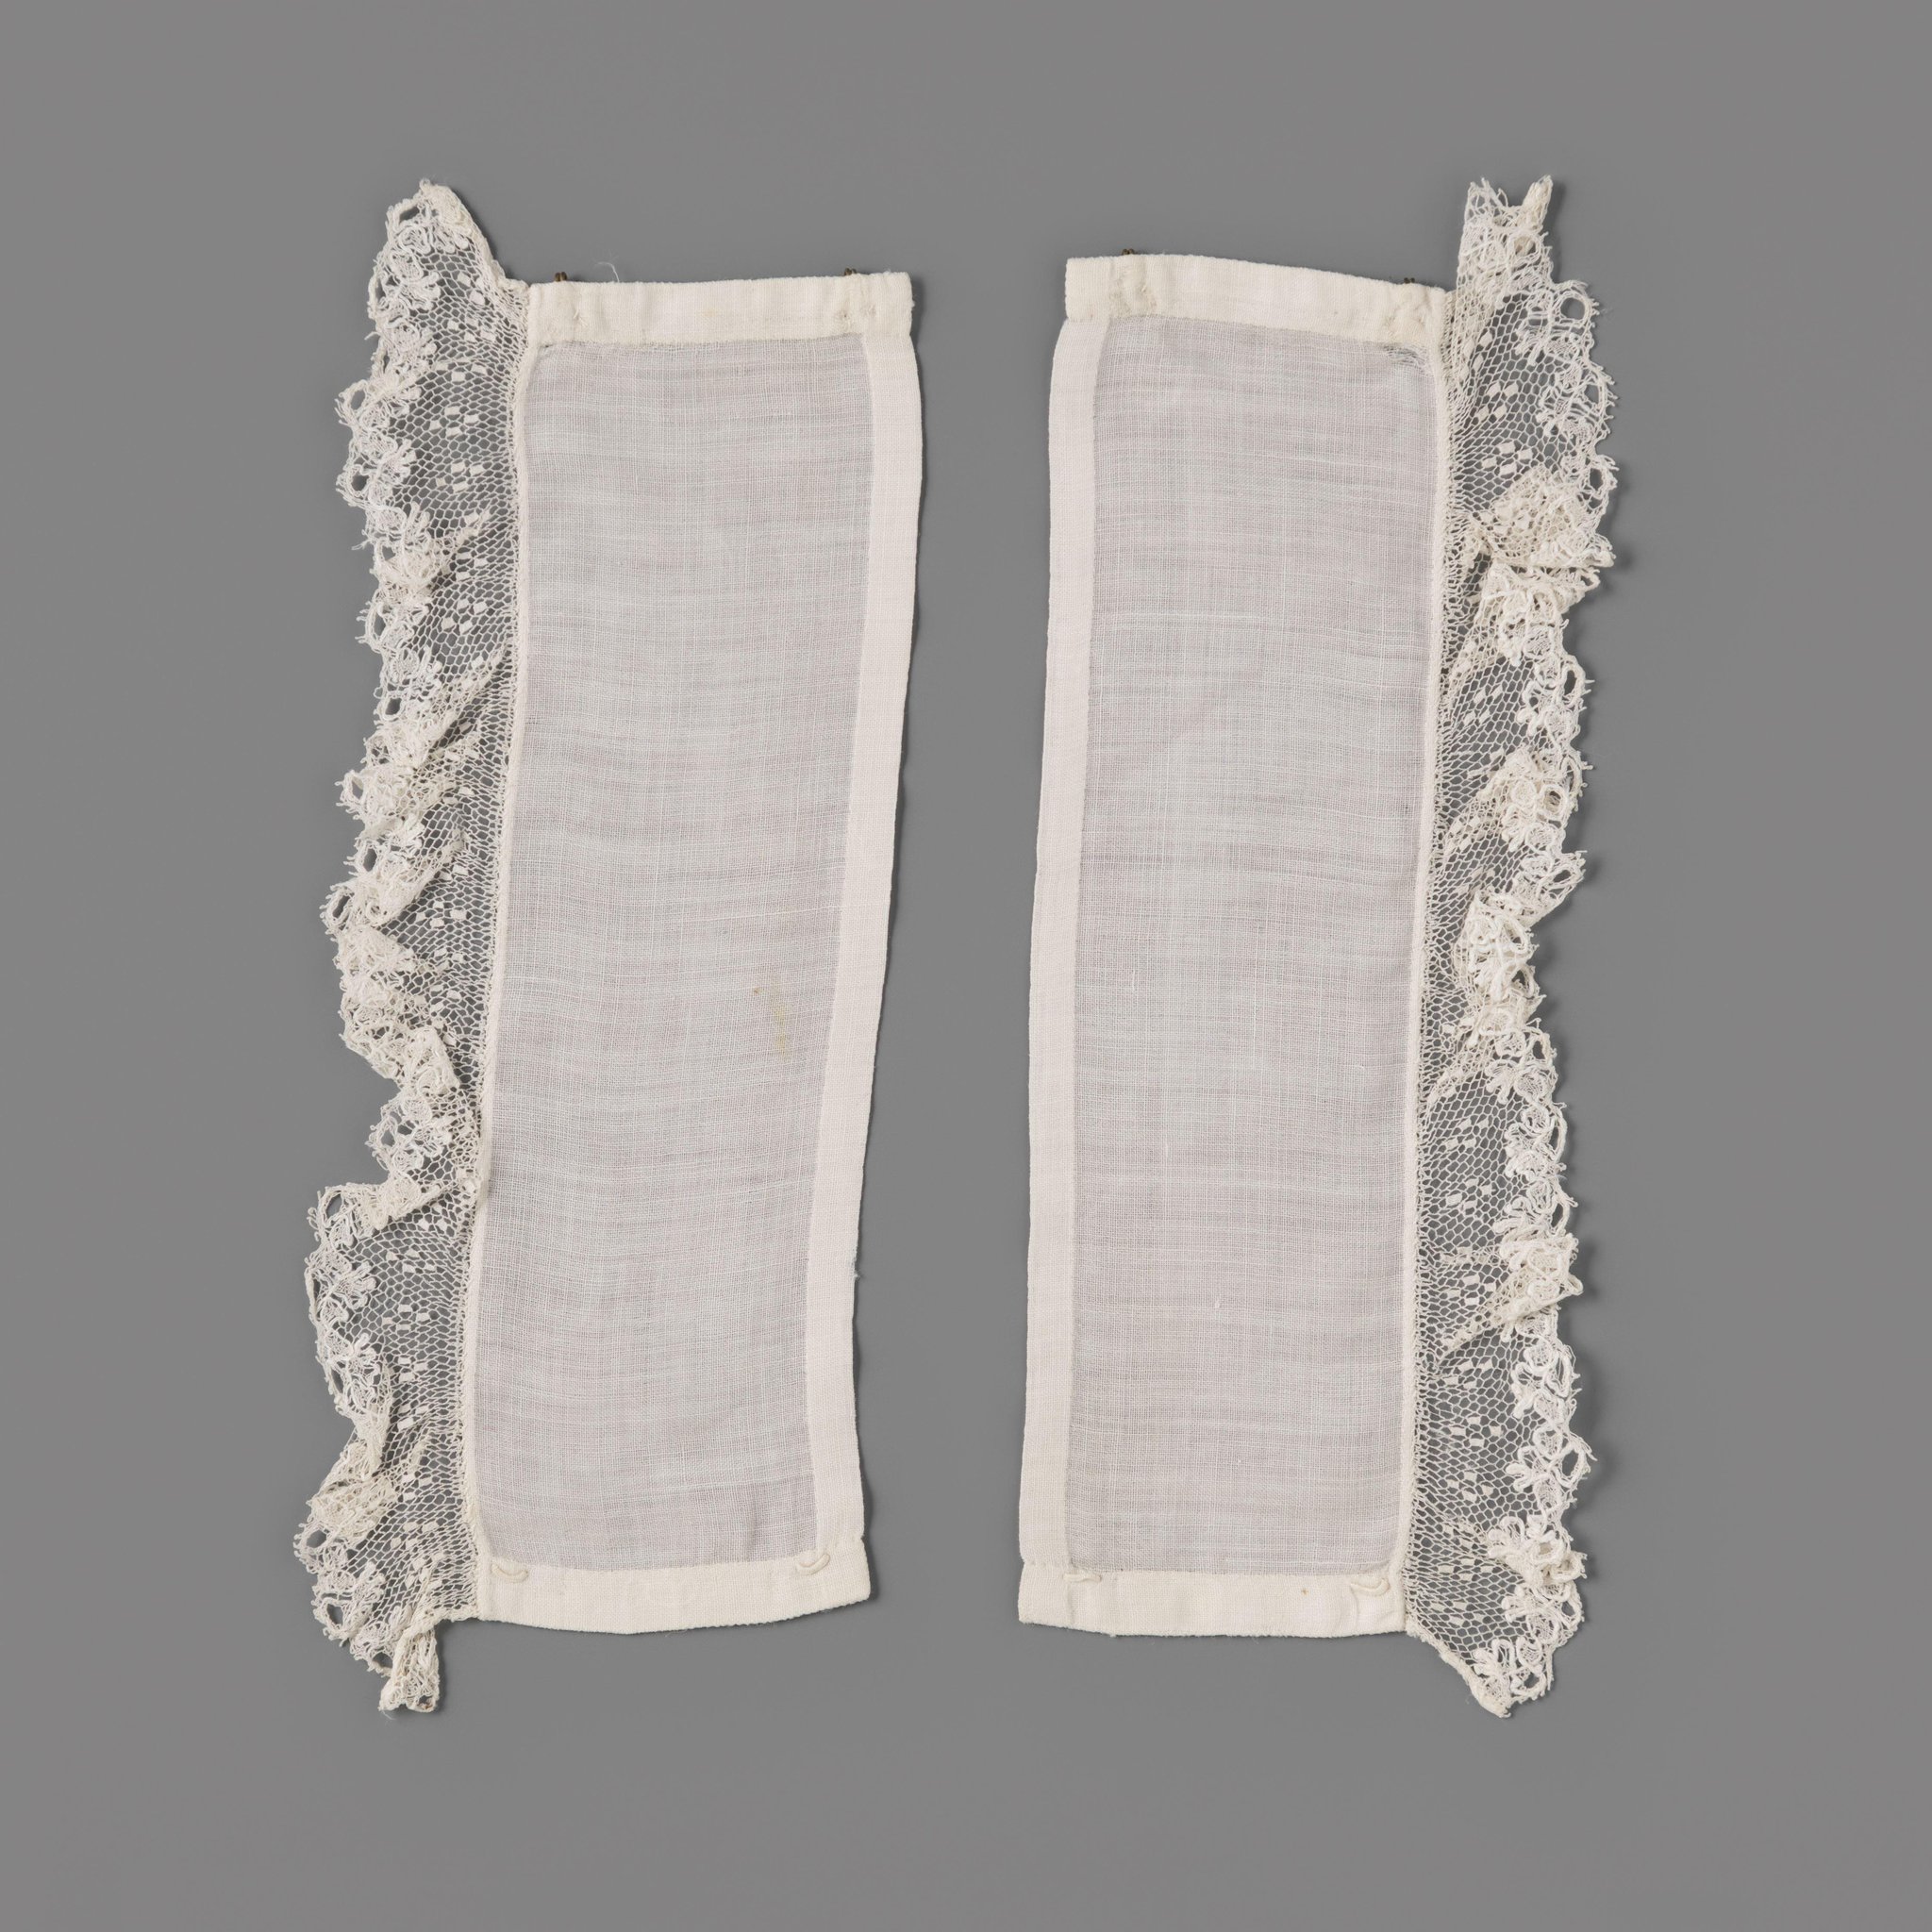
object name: cuff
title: Manchet van batist met aangerimpelde strook Rijsselse kant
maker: Anonymous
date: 1880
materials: textile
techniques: cockled, lace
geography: western europe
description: Manchet van batist met aangerimpelde strook Rijsselse kant. Het kant heeft een schulprand van bloemen en moesjes in ruiten. De manchet kan worden gesloten door midden van twee haken.